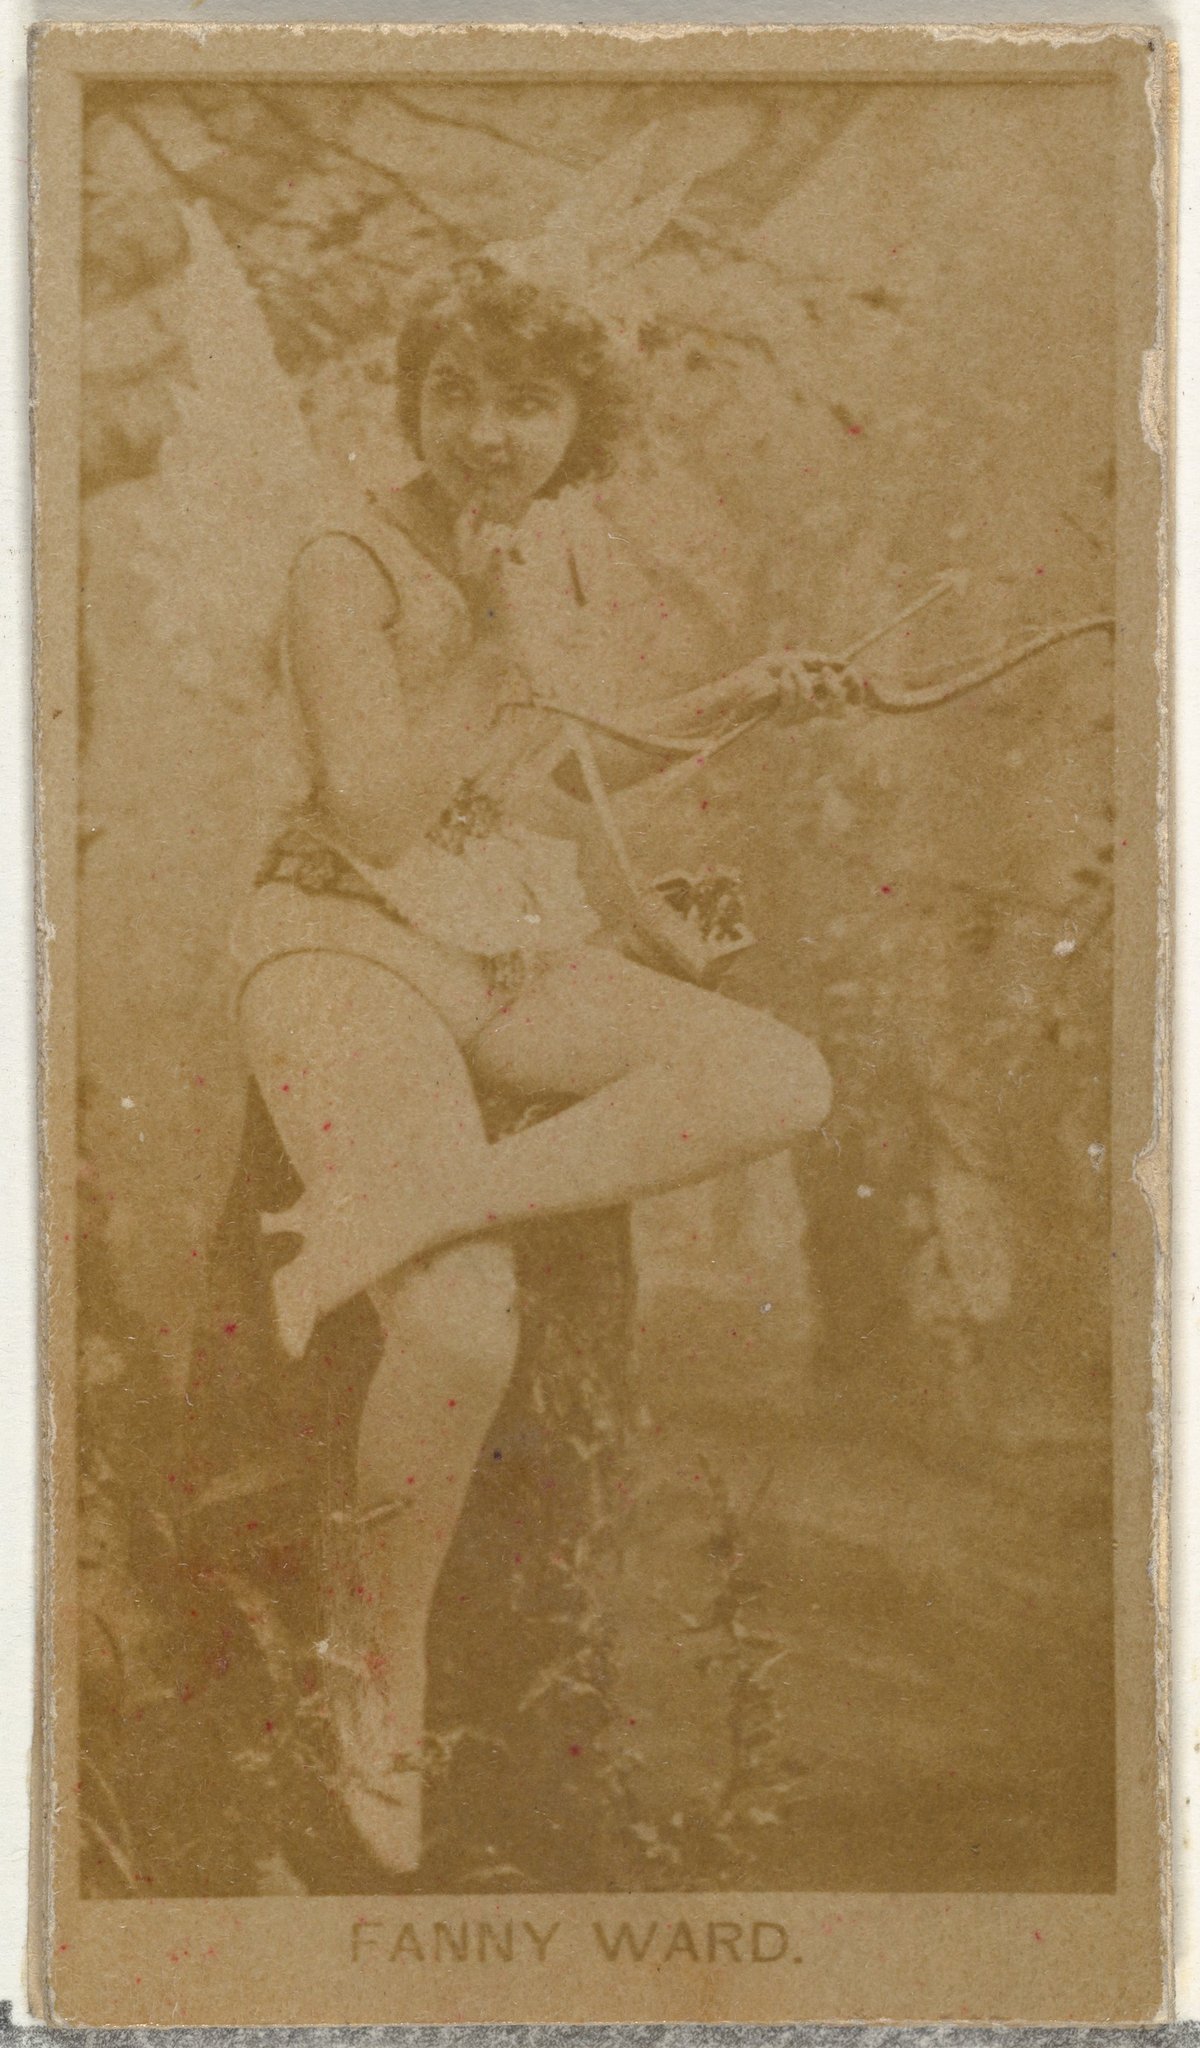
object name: photograph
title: Fanny Ward, from the Actors and Actresses series (N145-8) issued by Duke Sons & Co. to promote Duke Cigarettes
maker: w. duke, sons & co.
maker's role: publisher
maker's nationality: american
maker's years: 1870-1920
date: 1891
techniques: albumen silver print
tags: portraits,women,actresses